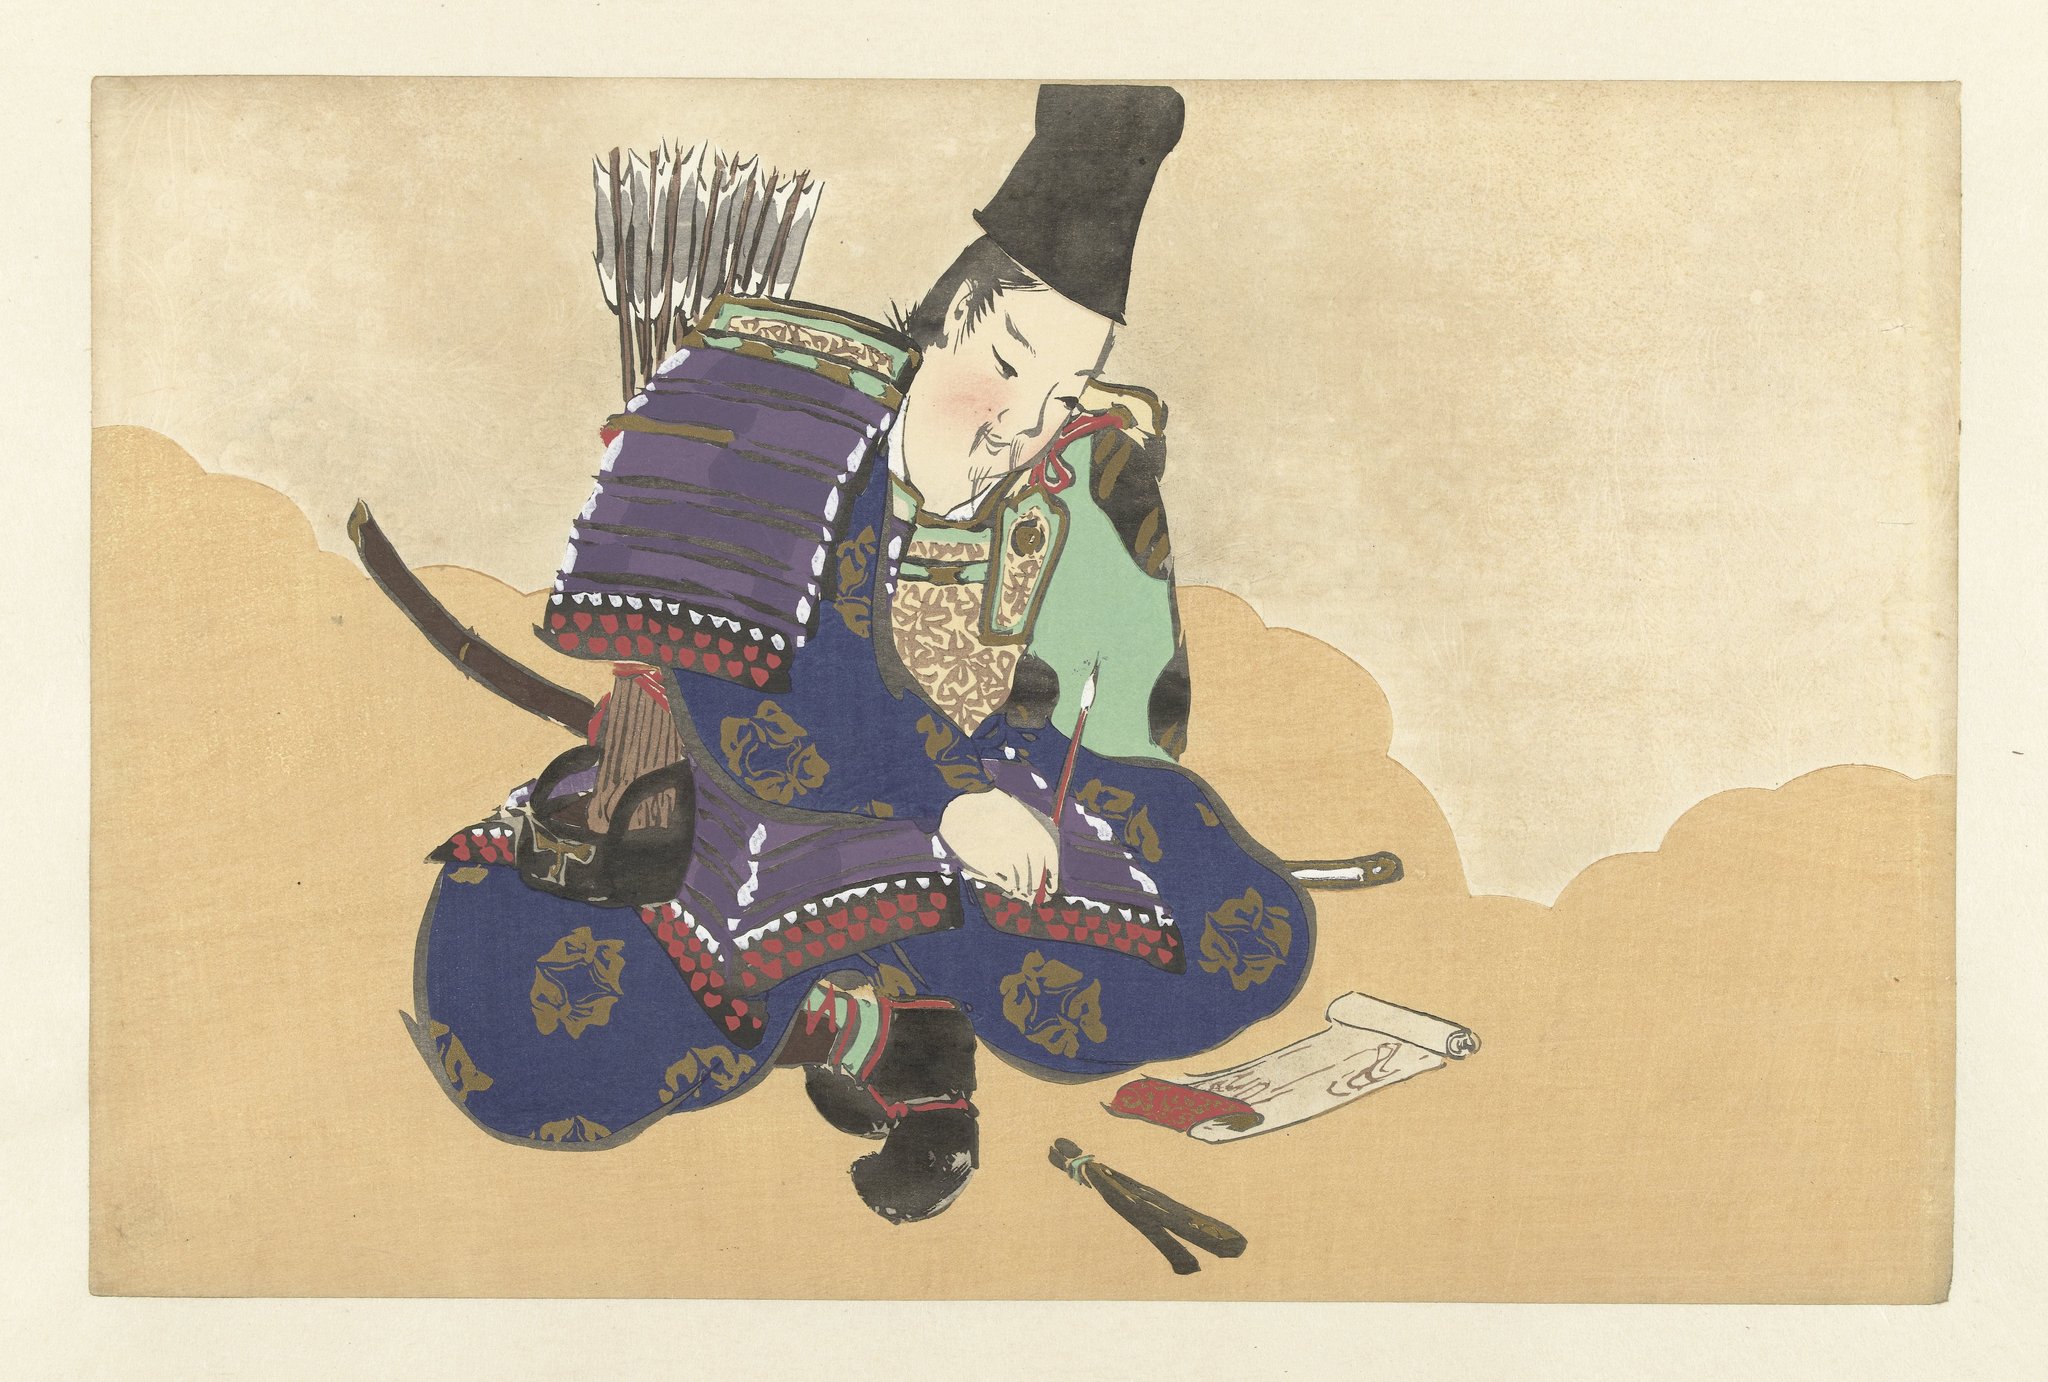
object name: print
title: Momoyogusa, dl. 1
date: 1909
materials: paper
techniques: woodcut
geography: kyoto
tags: writing accessories, sitting on the ground, japan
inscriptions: collector's mark: Lugt 2228, collector's mark: Lugt 2760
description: Tadanori, samoerai van de Taira clan, zittend op de grond met een penseel in de hand, rol papier voor zich.